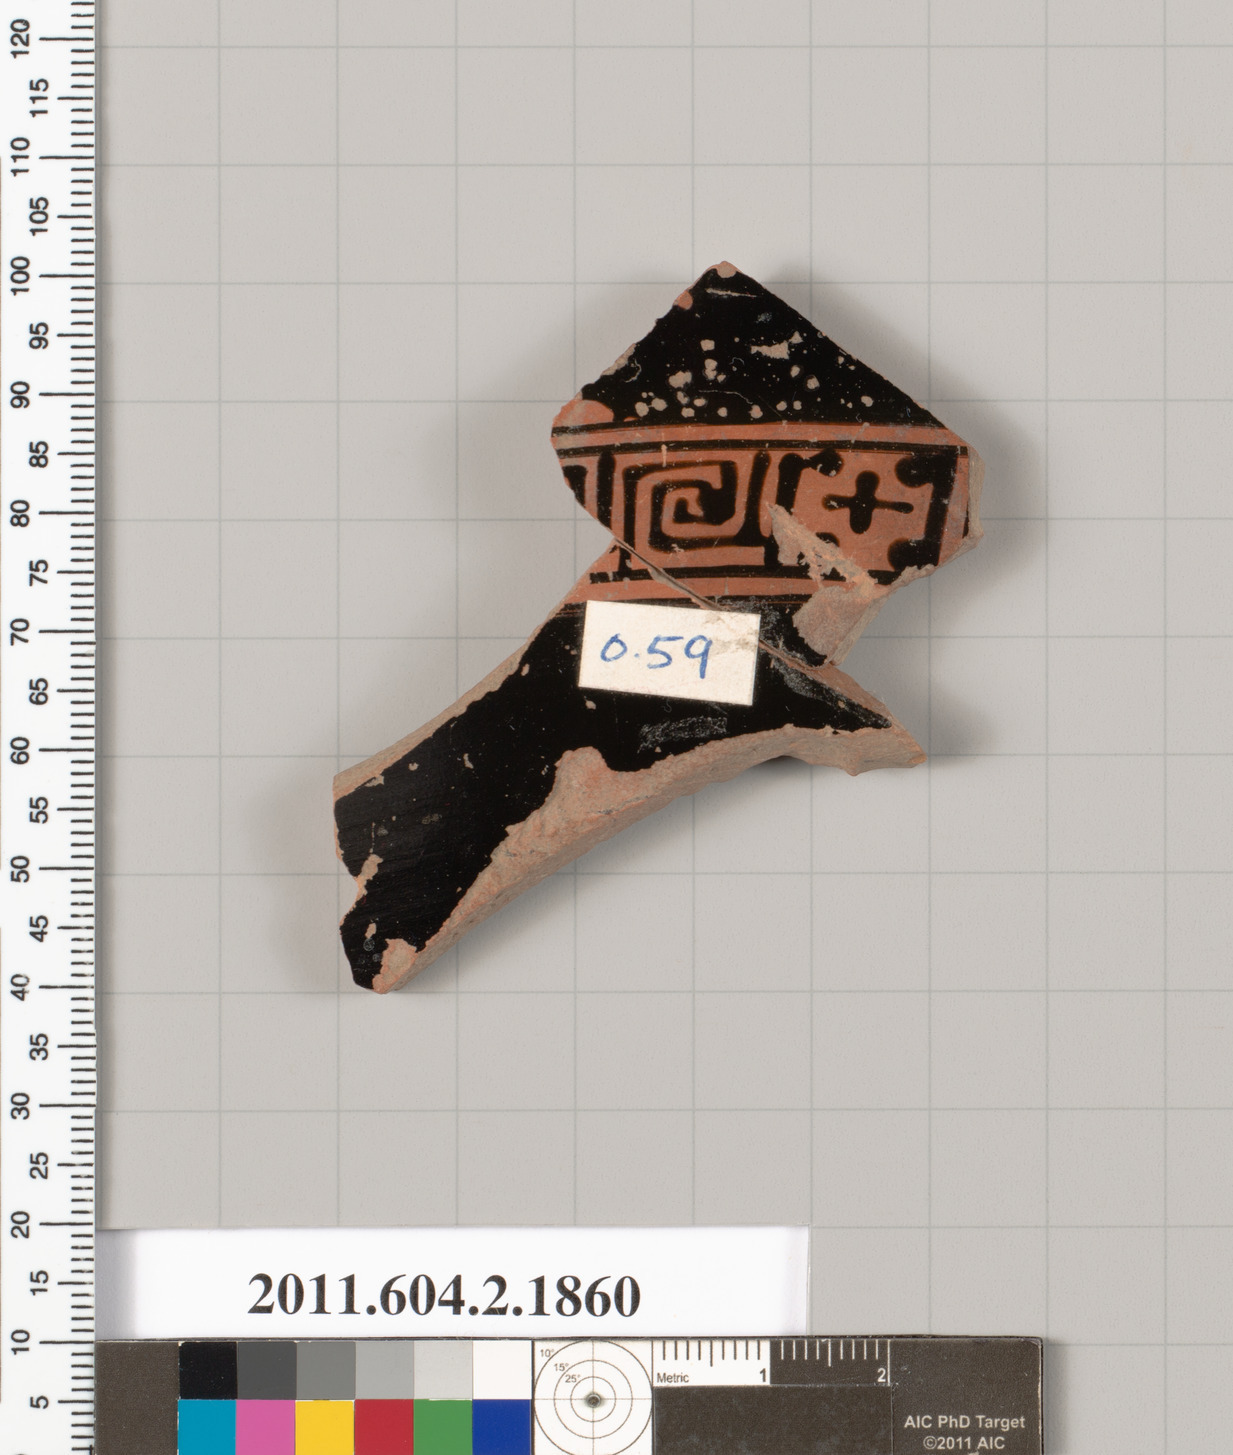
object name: skyphos fragment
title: Terracotta fragment of a skyphos (deep drinking cup)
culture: greek, attic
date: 460-450 BCE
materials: terracotta